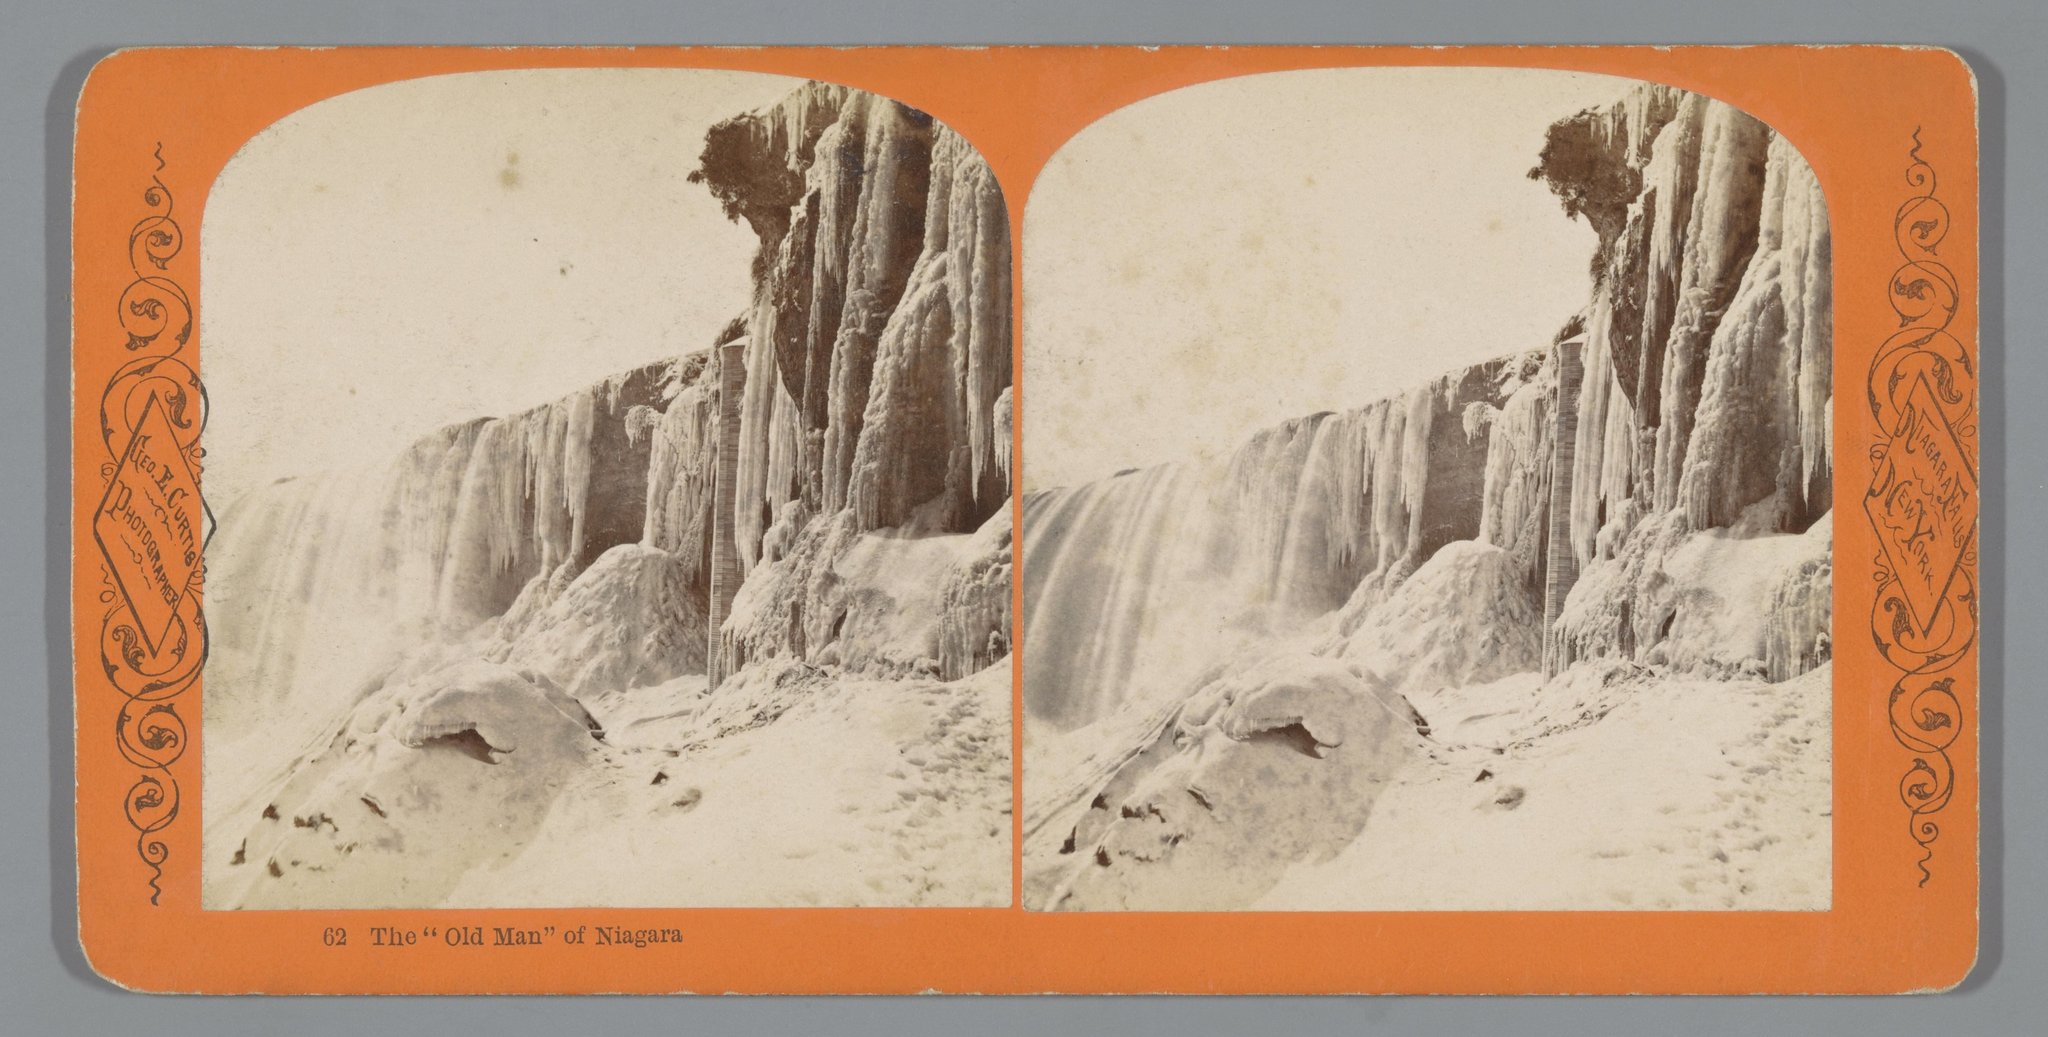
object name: stereograph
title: The "Old Man" of Niagara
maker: george e. curtis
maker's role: fotograaf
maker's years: 1830-1910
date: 1866-1910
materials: cardboard, paper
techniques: albumen print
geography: niagara falls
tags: icicle, waterfall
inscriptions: number: ‘62’